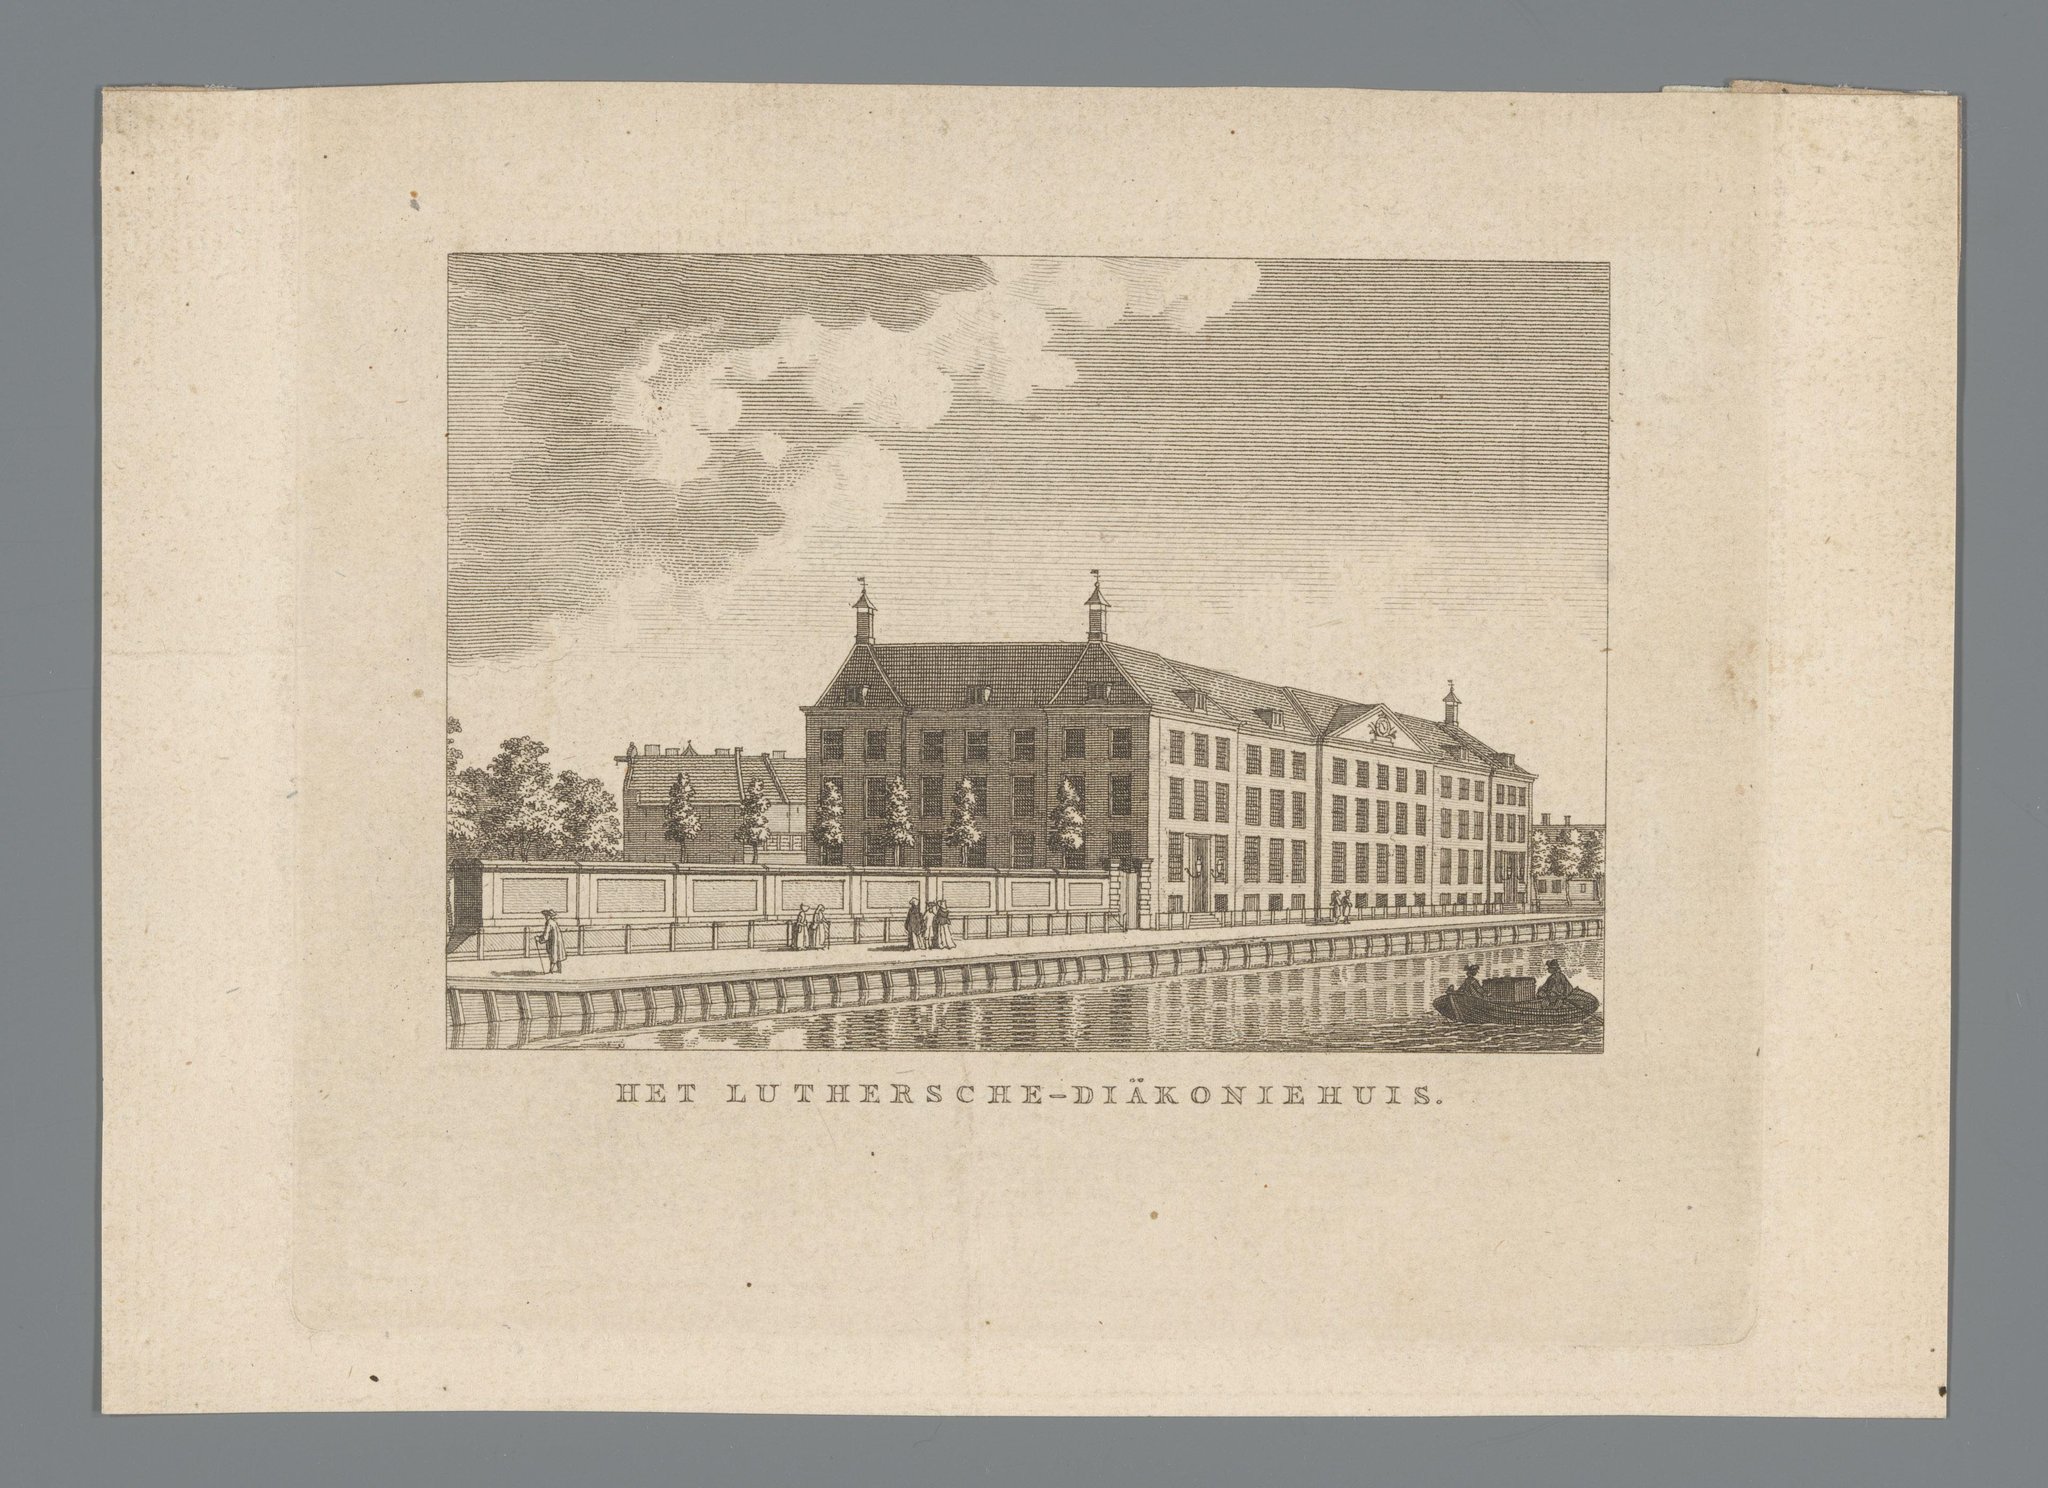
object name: book illustration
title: Gezicht op het Lutherse Diaconiehuis te Amsterdam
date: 1789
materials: paper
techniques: etching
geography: amsterdam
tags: public welfare, canals, waters (in city), exterior ~ representation of a building, street (+ city(-scape) with figures, staffage)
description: Prent uit: Amsteldam en zyne geschiedenissen, in 't kort. Amsterdam: Johannes Allart, 1789, dl. 3, tussen p. 218 en 219.